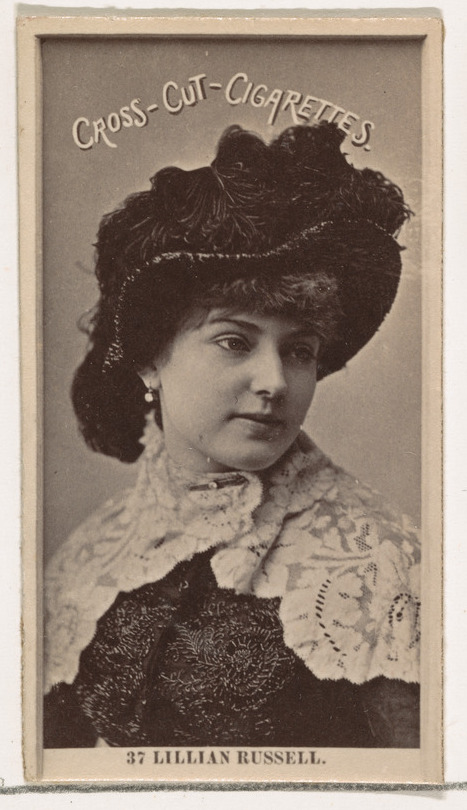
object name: print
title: Card Number 37, Lillian Russell, from the Actors and Actresses series (N145-2) issued by Duke Sons & Co. to promote Cross Cut Cigarettes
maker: w. duke, sons & co.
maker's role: publisher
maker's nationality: american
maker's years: 1870-1920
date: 1880-1889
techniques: albumen silver print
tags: portraits,women,actresses